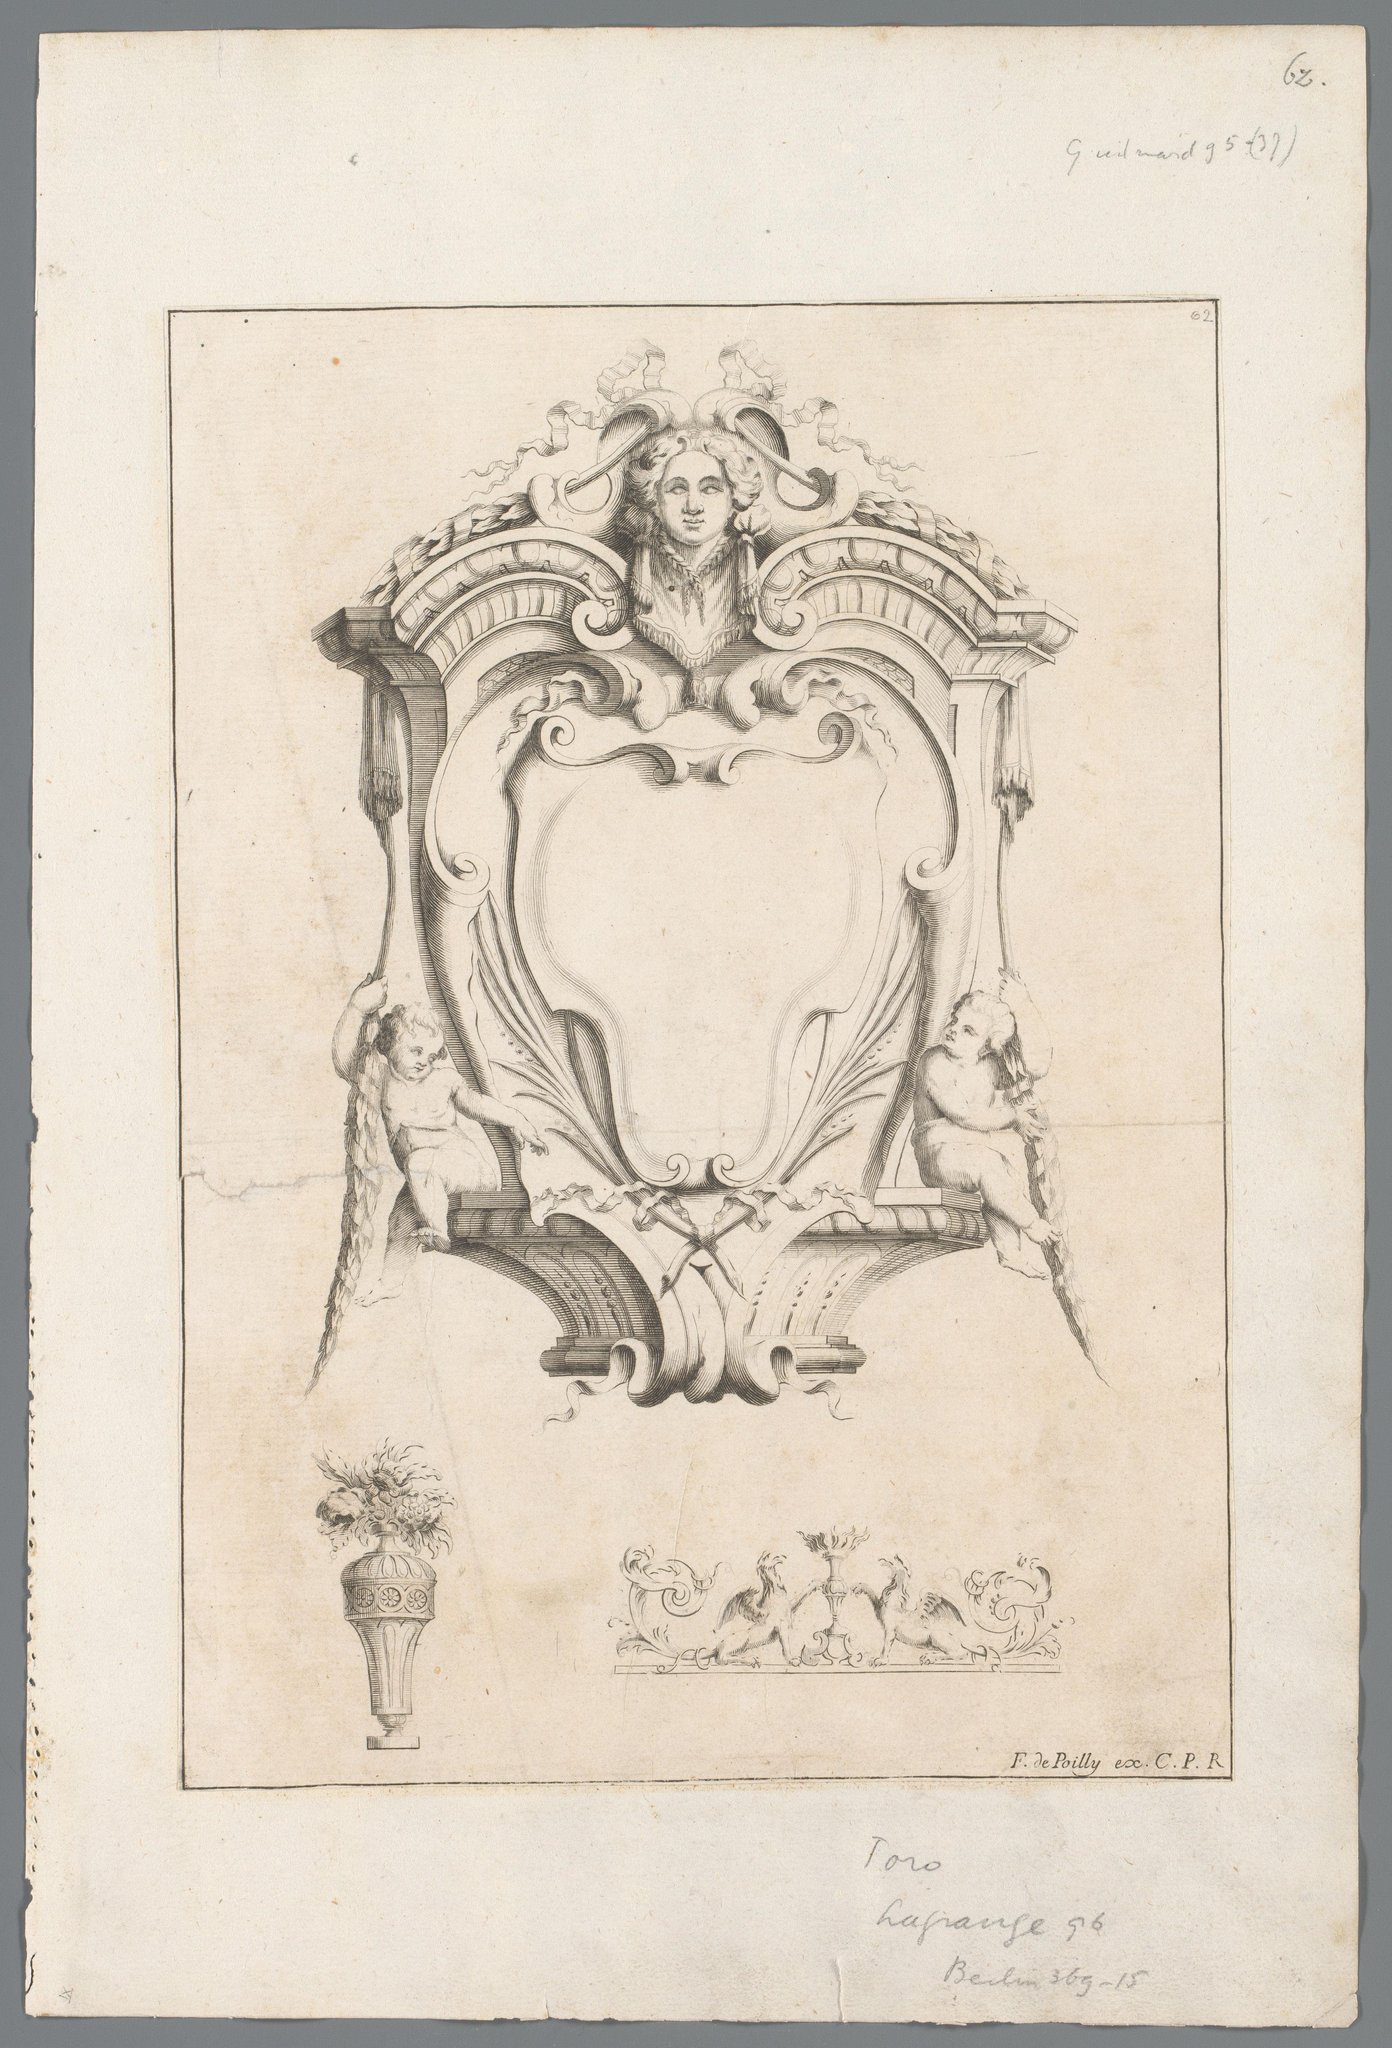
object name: ornament print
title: Livre nouveau de cartouche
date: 1682-1723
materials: paper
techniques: engraving, etching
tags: ornament ~ cartouche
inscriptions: collector's mark: Lugt 2760, collector's mark: Lugt 2228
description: Prent maakt deel uit van een serie van zes prenten.